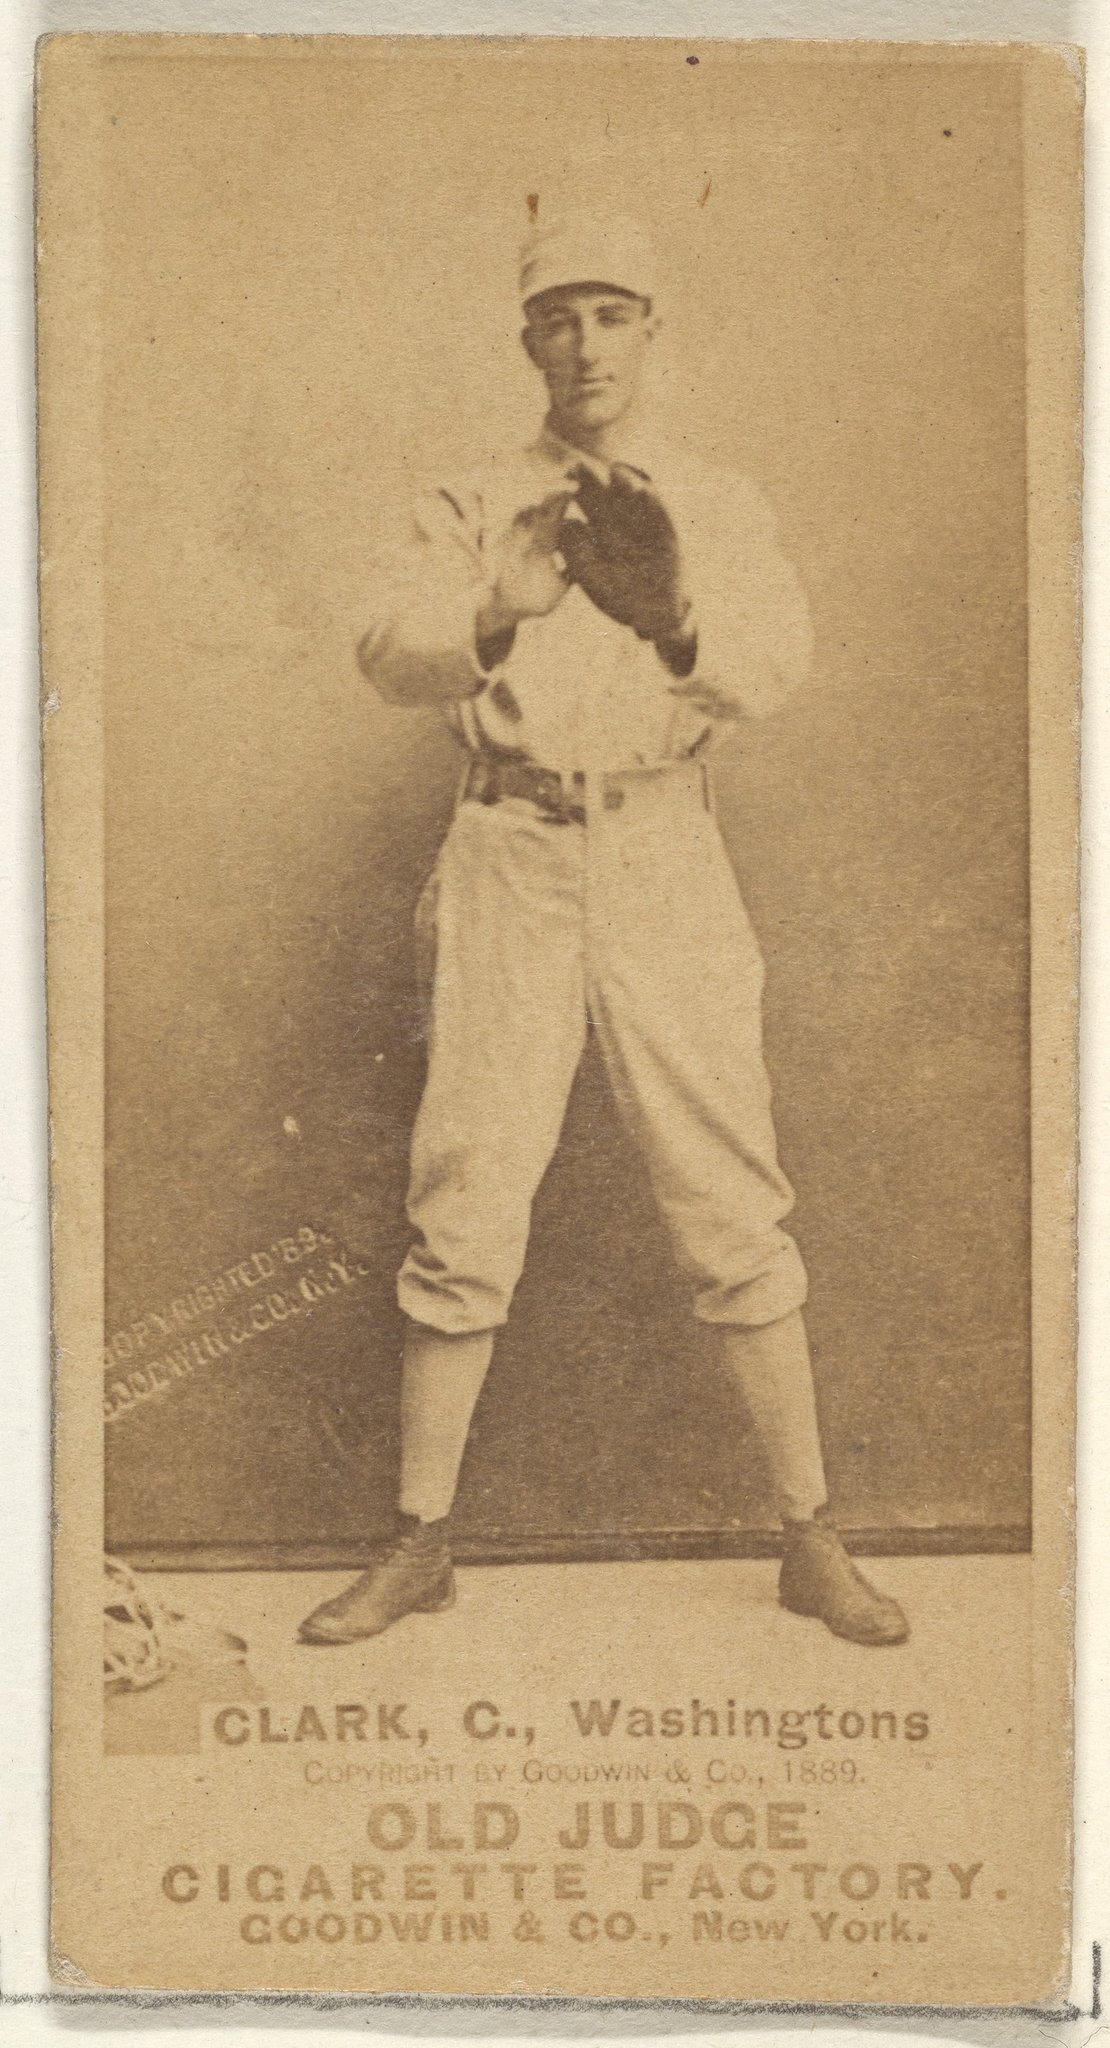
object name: baseball card, photograph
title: Owen F. "Spider" Clark, Catcher, Washington Nationals, from the Old Judge series (N172) for Old Judge Cigarettes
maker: goodwin & company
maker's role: publisher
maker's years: 1850-1950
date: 1889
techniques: albumen silver print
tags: men,portraits,baseball,athletes